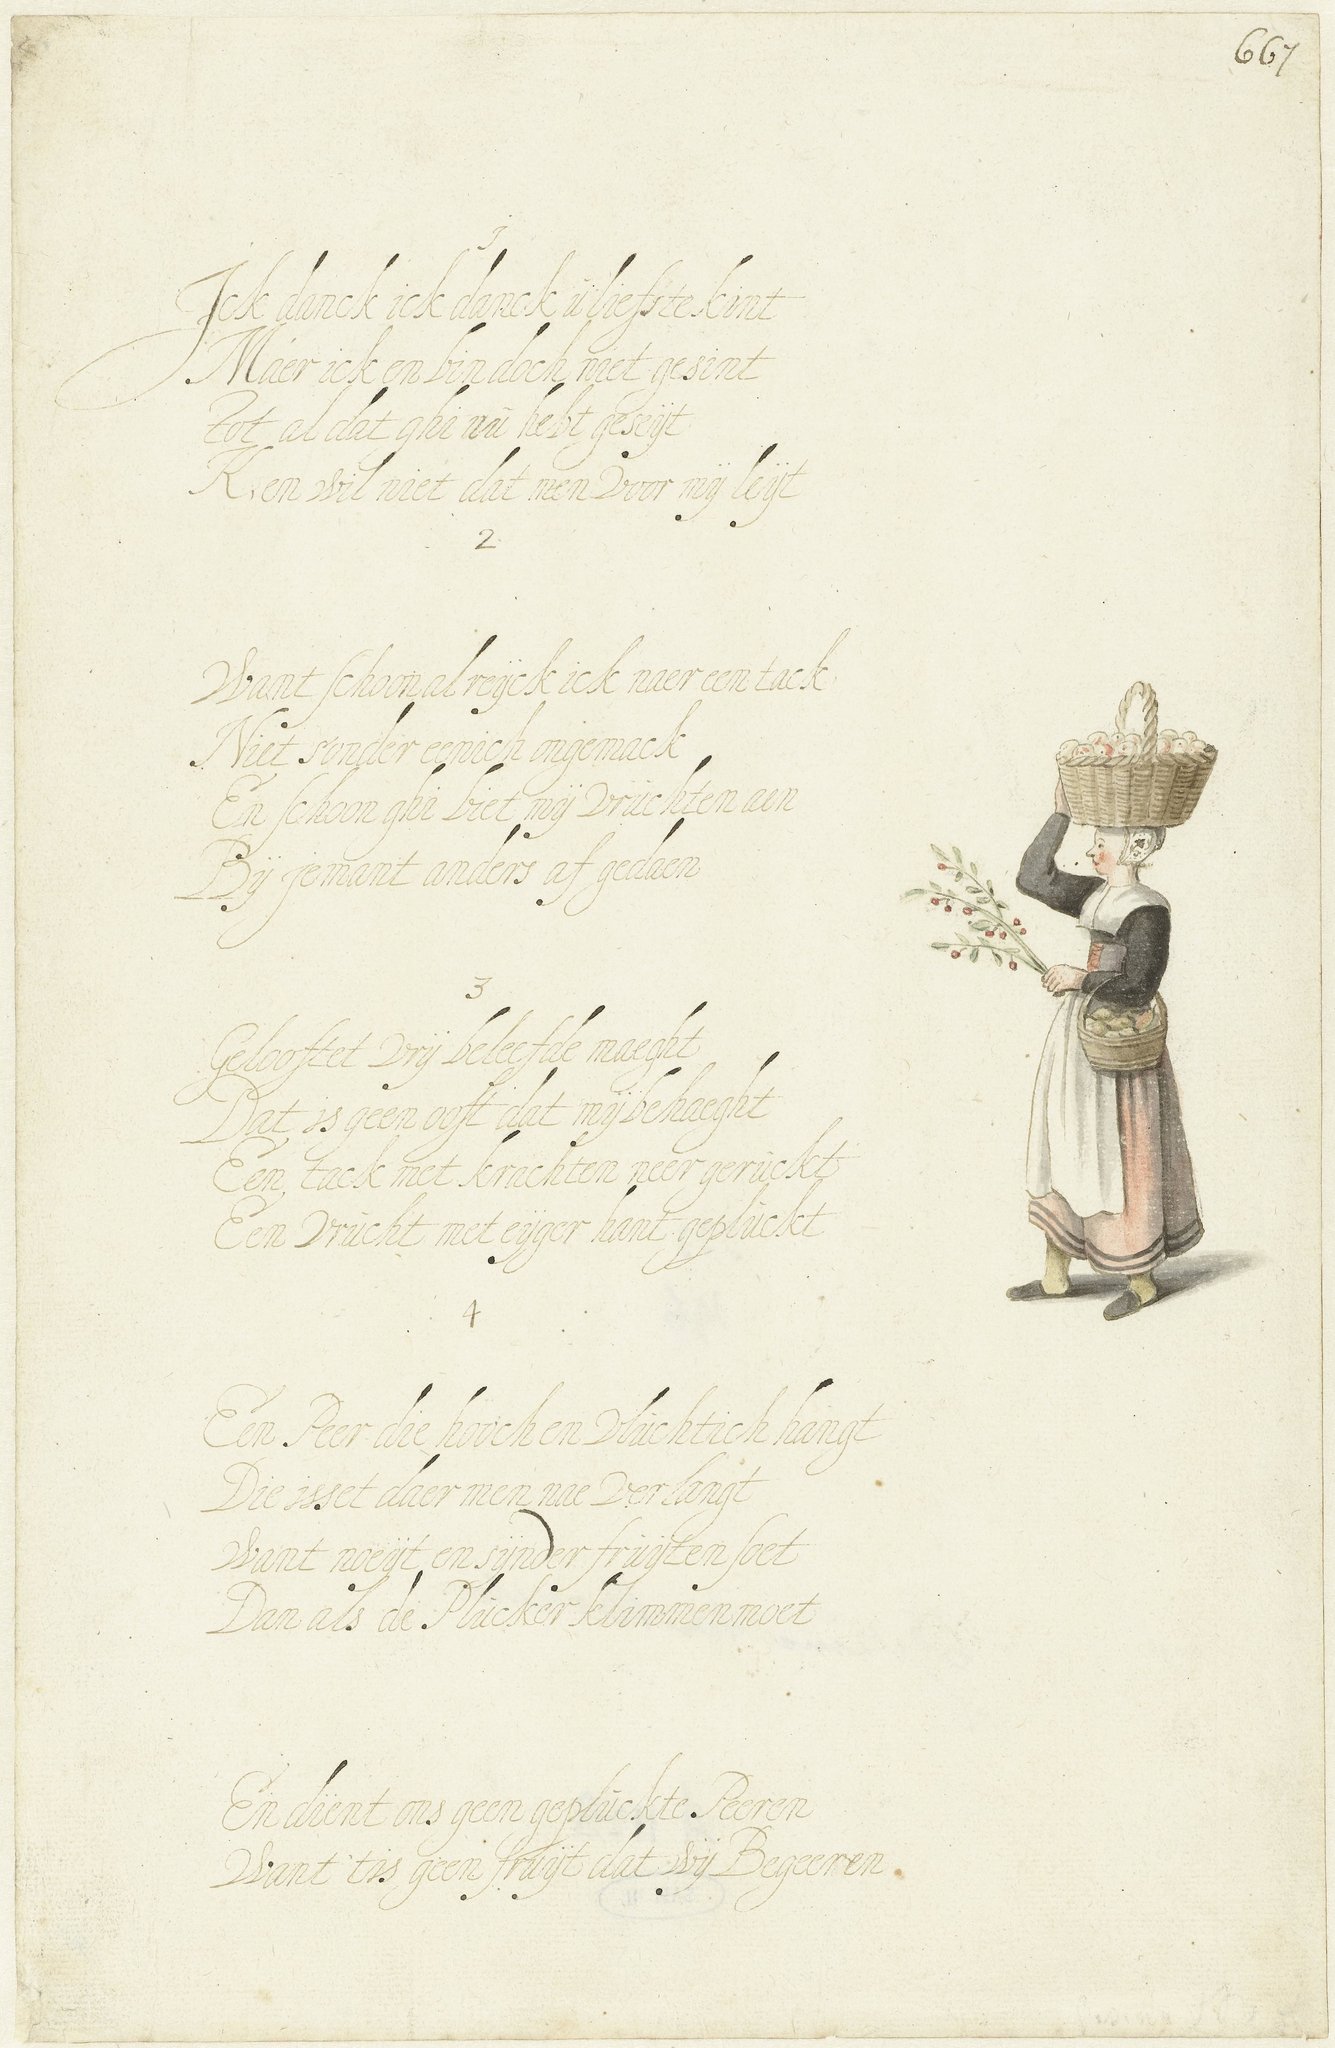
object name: drawing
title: Woman with Two Baskets of Fruit and a Cherry Branch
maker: gesina ter borch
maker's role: draughtsman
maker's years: 1633-1690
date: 1652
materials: ink, paper, watercolor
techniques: brush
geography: zwolle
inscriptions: poem: ‘gedicht van Jacob Cats’, signature: ‘Gezina ter Borch’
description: The motto at the bottom of the sheet explains the connection between the drawing of a woman carrying fruit and Jacob Cats’ poem about chastity. After all, it is better to pick fruit yourself than to accept ‘pearsthat have already been plucked,’ alluding to promiscuity. In this early drawing, Gesina ter Borch opted for a simple illustration to accompany the text. Years later, in her Poëzie-album (Poetry Album), she would provide the same poem with a more complex composition.